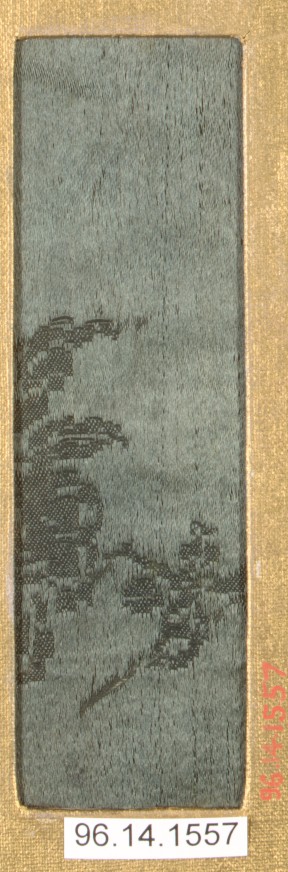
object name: piece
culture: japanese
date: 1701-1900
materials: silk